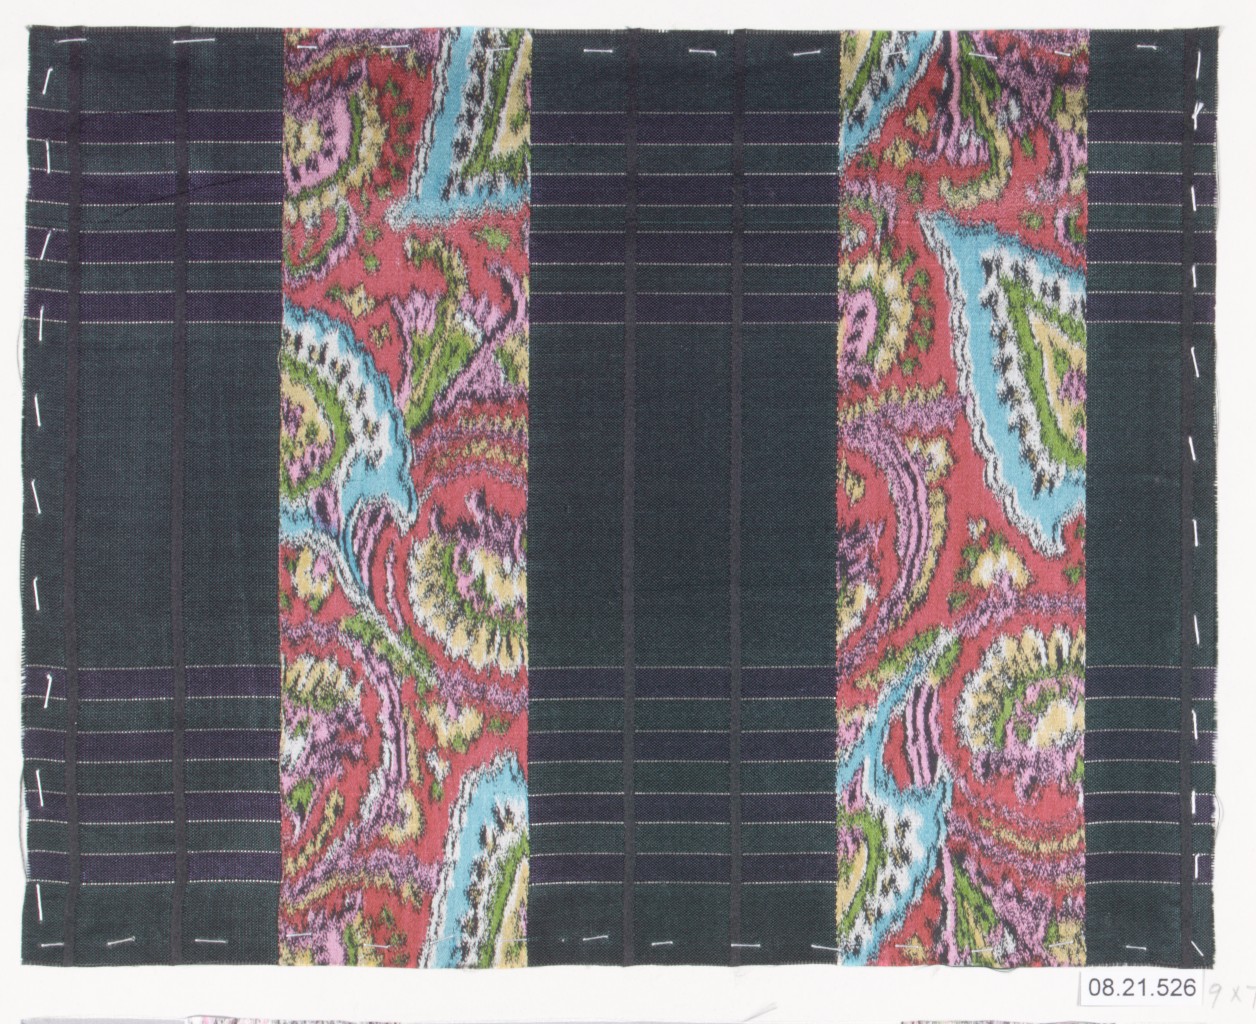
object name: textile sample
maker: Anonymous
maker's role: designer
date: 1900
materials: silk